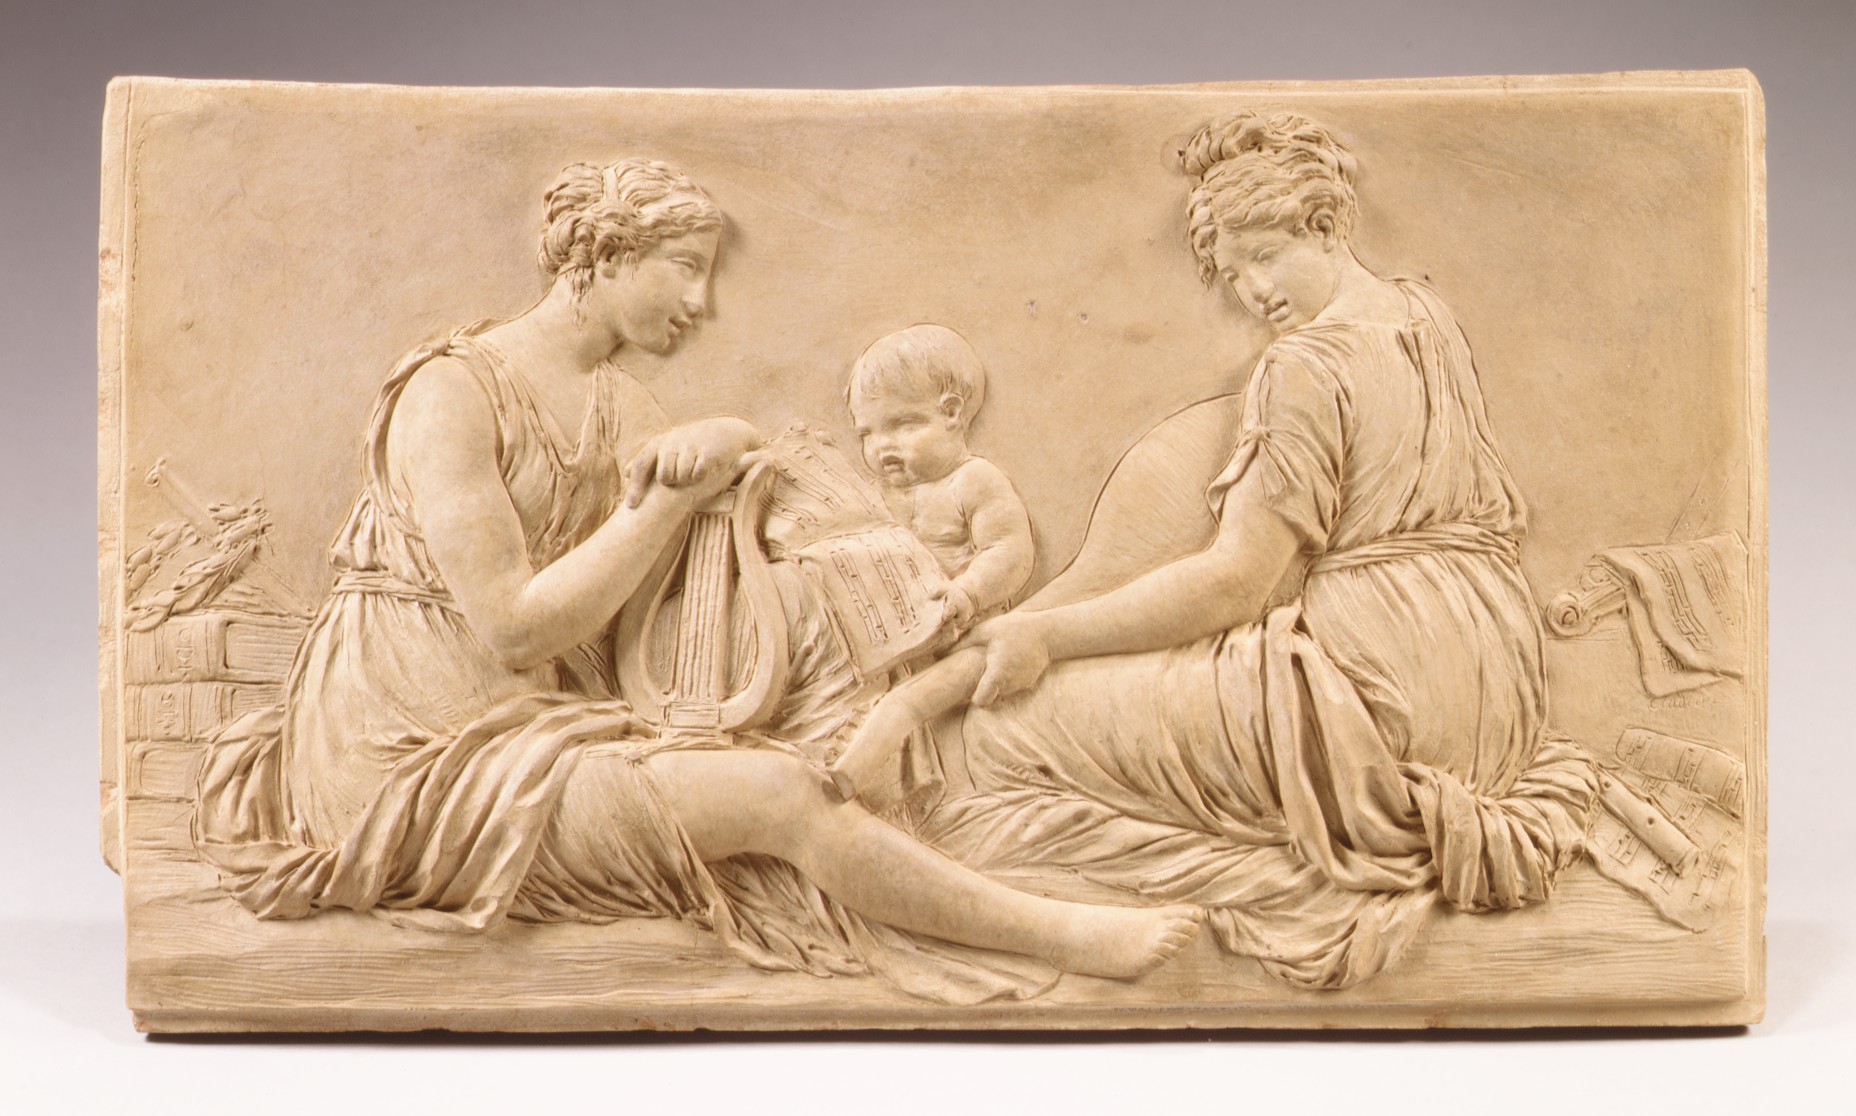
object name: relief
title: Music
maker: clodion (claude michel)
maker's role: artist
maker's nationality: french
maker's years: 1738-1814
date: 1780-1790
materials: terracotta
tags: musical instruments,infants,women,music